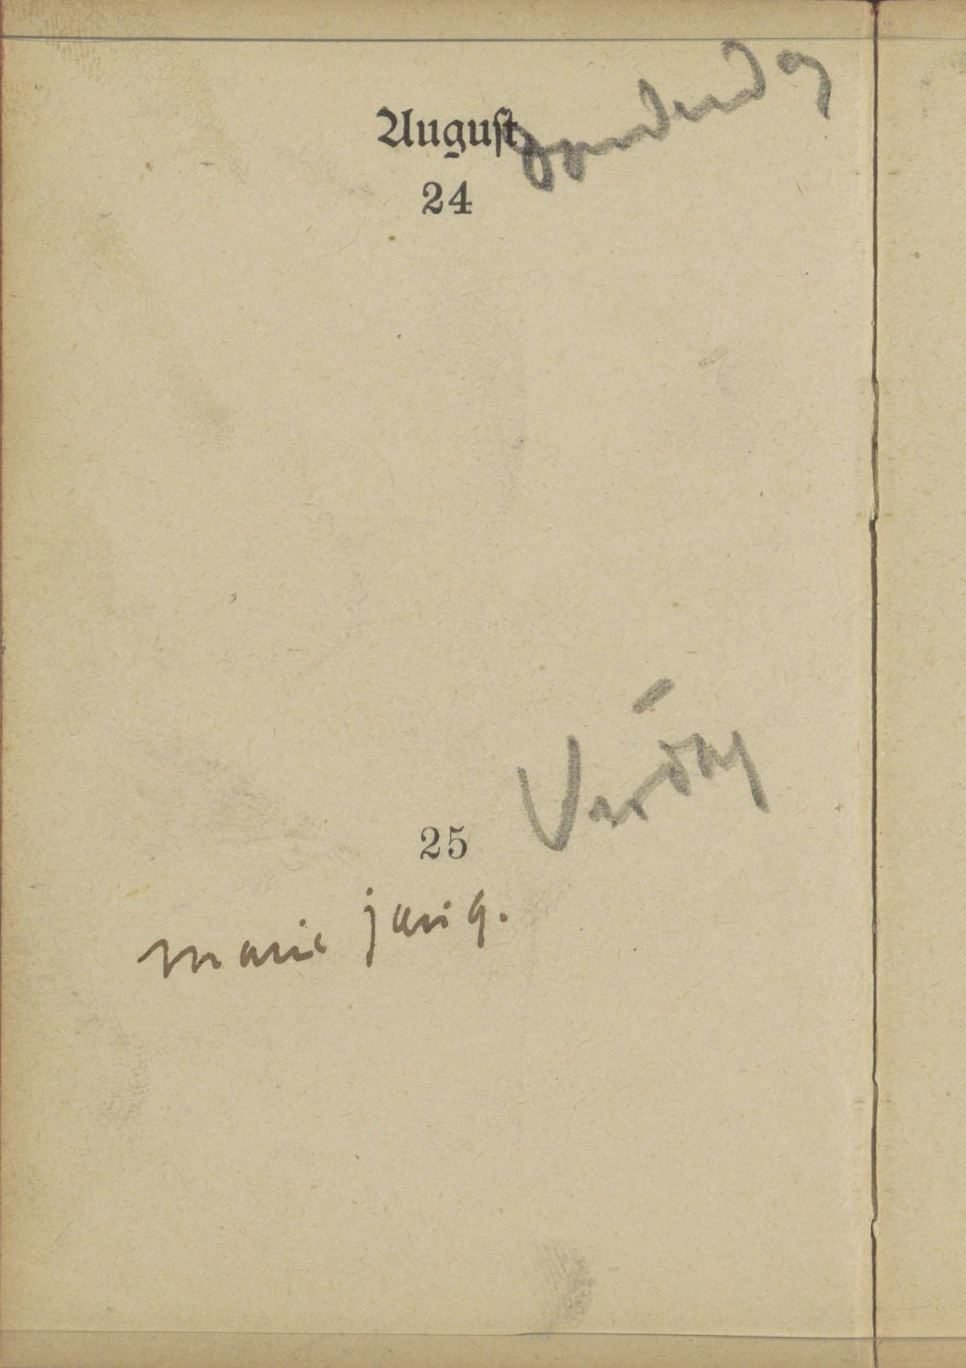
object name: sketchbook leaf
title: Annotatie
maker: george hendrik breitner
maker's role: draughtsman, painter, print maker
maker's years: 1857-1923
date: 1893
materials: ink, paper, pencil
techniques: writing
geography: amsterdam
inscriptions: annotation: ‘Donderdag/ Vrijdag/ Maris jarig.’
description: Pagina 99 uit een als schetsboek gebruikte agenda met 80 bladen.